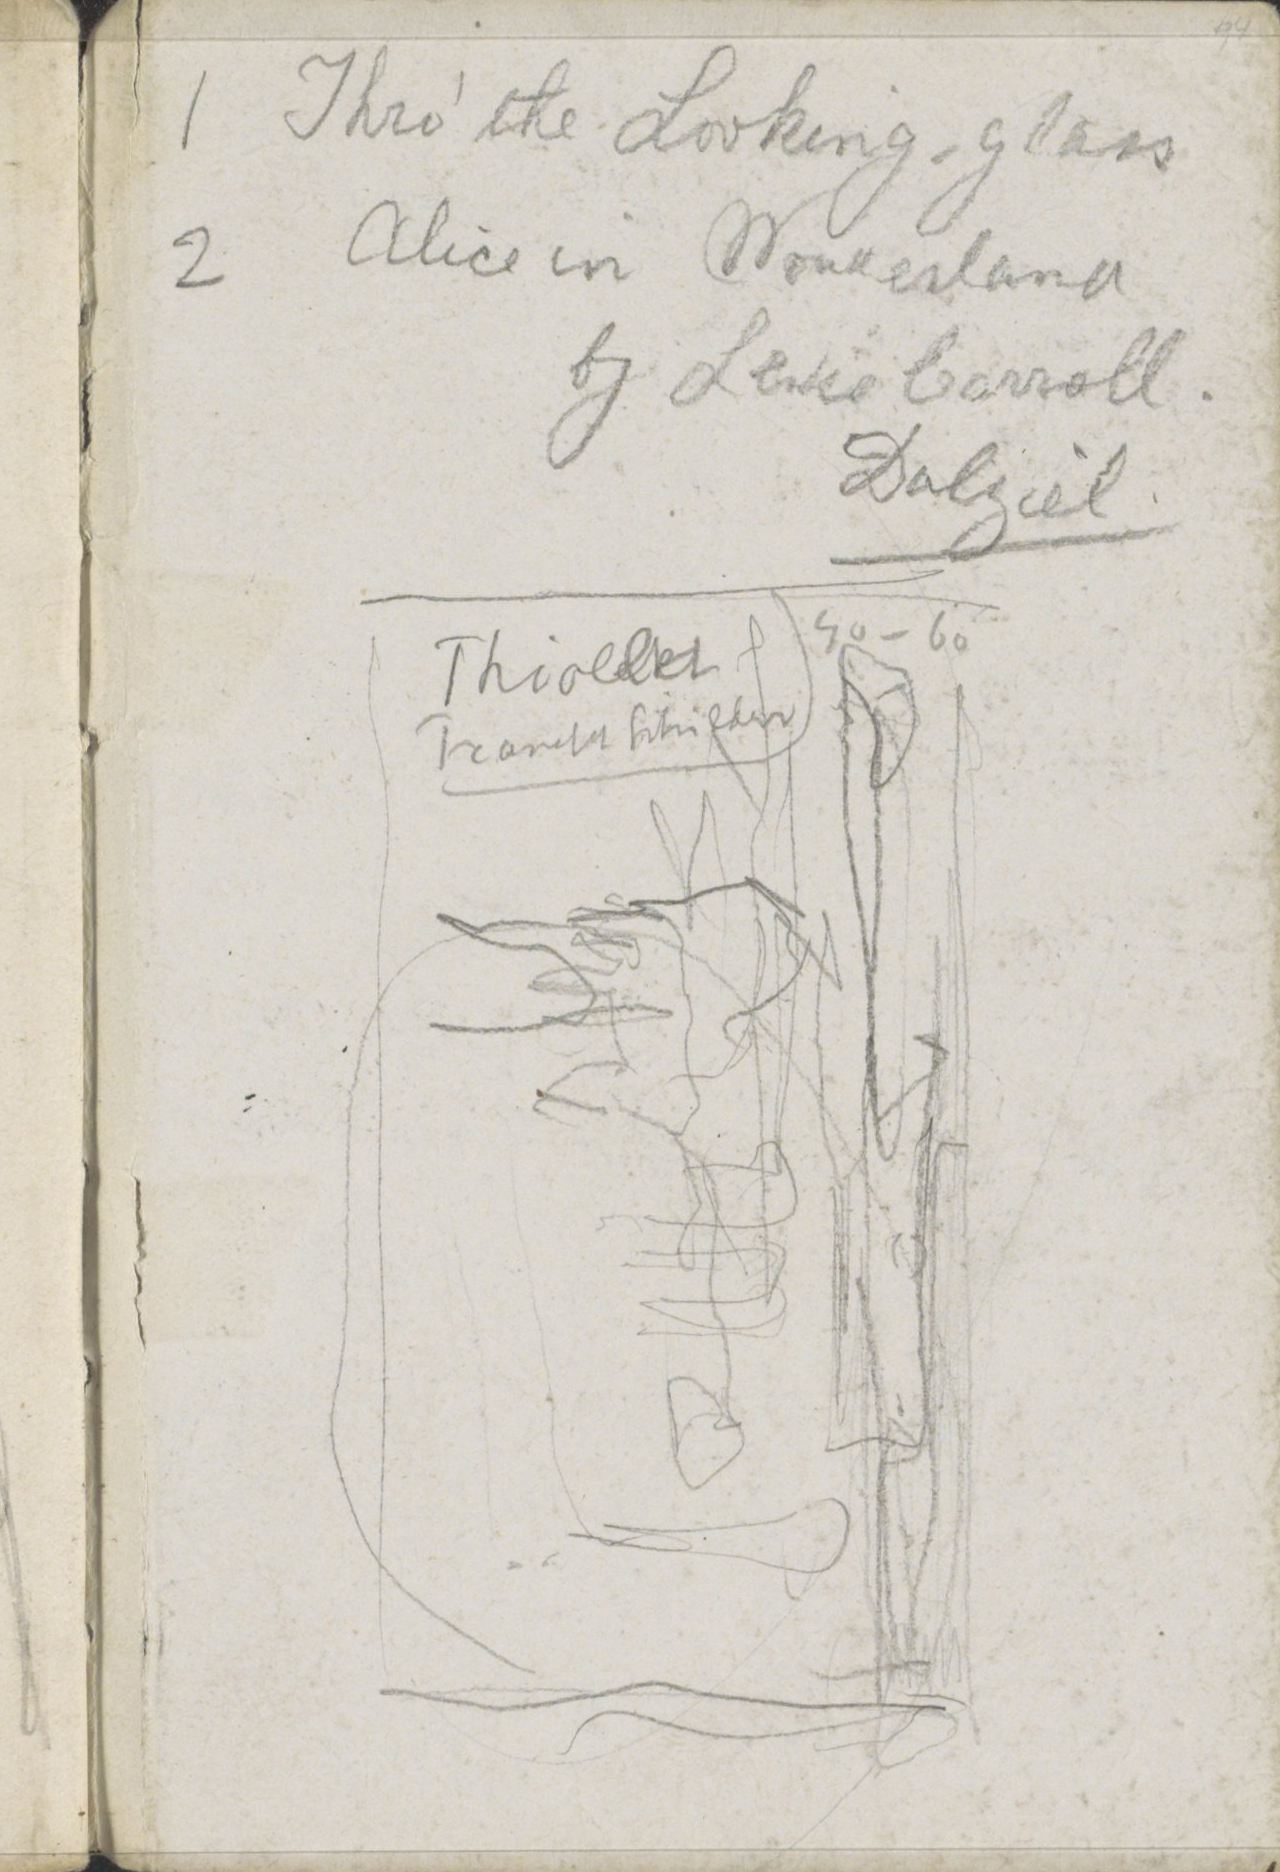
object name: sketchbook leaf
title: Studie, mogelijk een compositiestudie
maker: george hendrik breitner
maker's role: draughtsman, painter, print maker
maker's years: 1857-1923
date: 1909-1912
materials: paper, pencil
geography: amsterdam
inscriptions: name: ‘Thiollet/ Fransch schilder’, inscription: ‘1 Thro' the Looking-glass/ 2 Alice in Wonderland/ by Lewis Carroll./ Dal[...]iel’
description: Studie, mogelijk een compositiestudie. Pagina 94, achterste schutblad, uit een schetsboek met 46 bladen vervaardigd te Amsterdam.